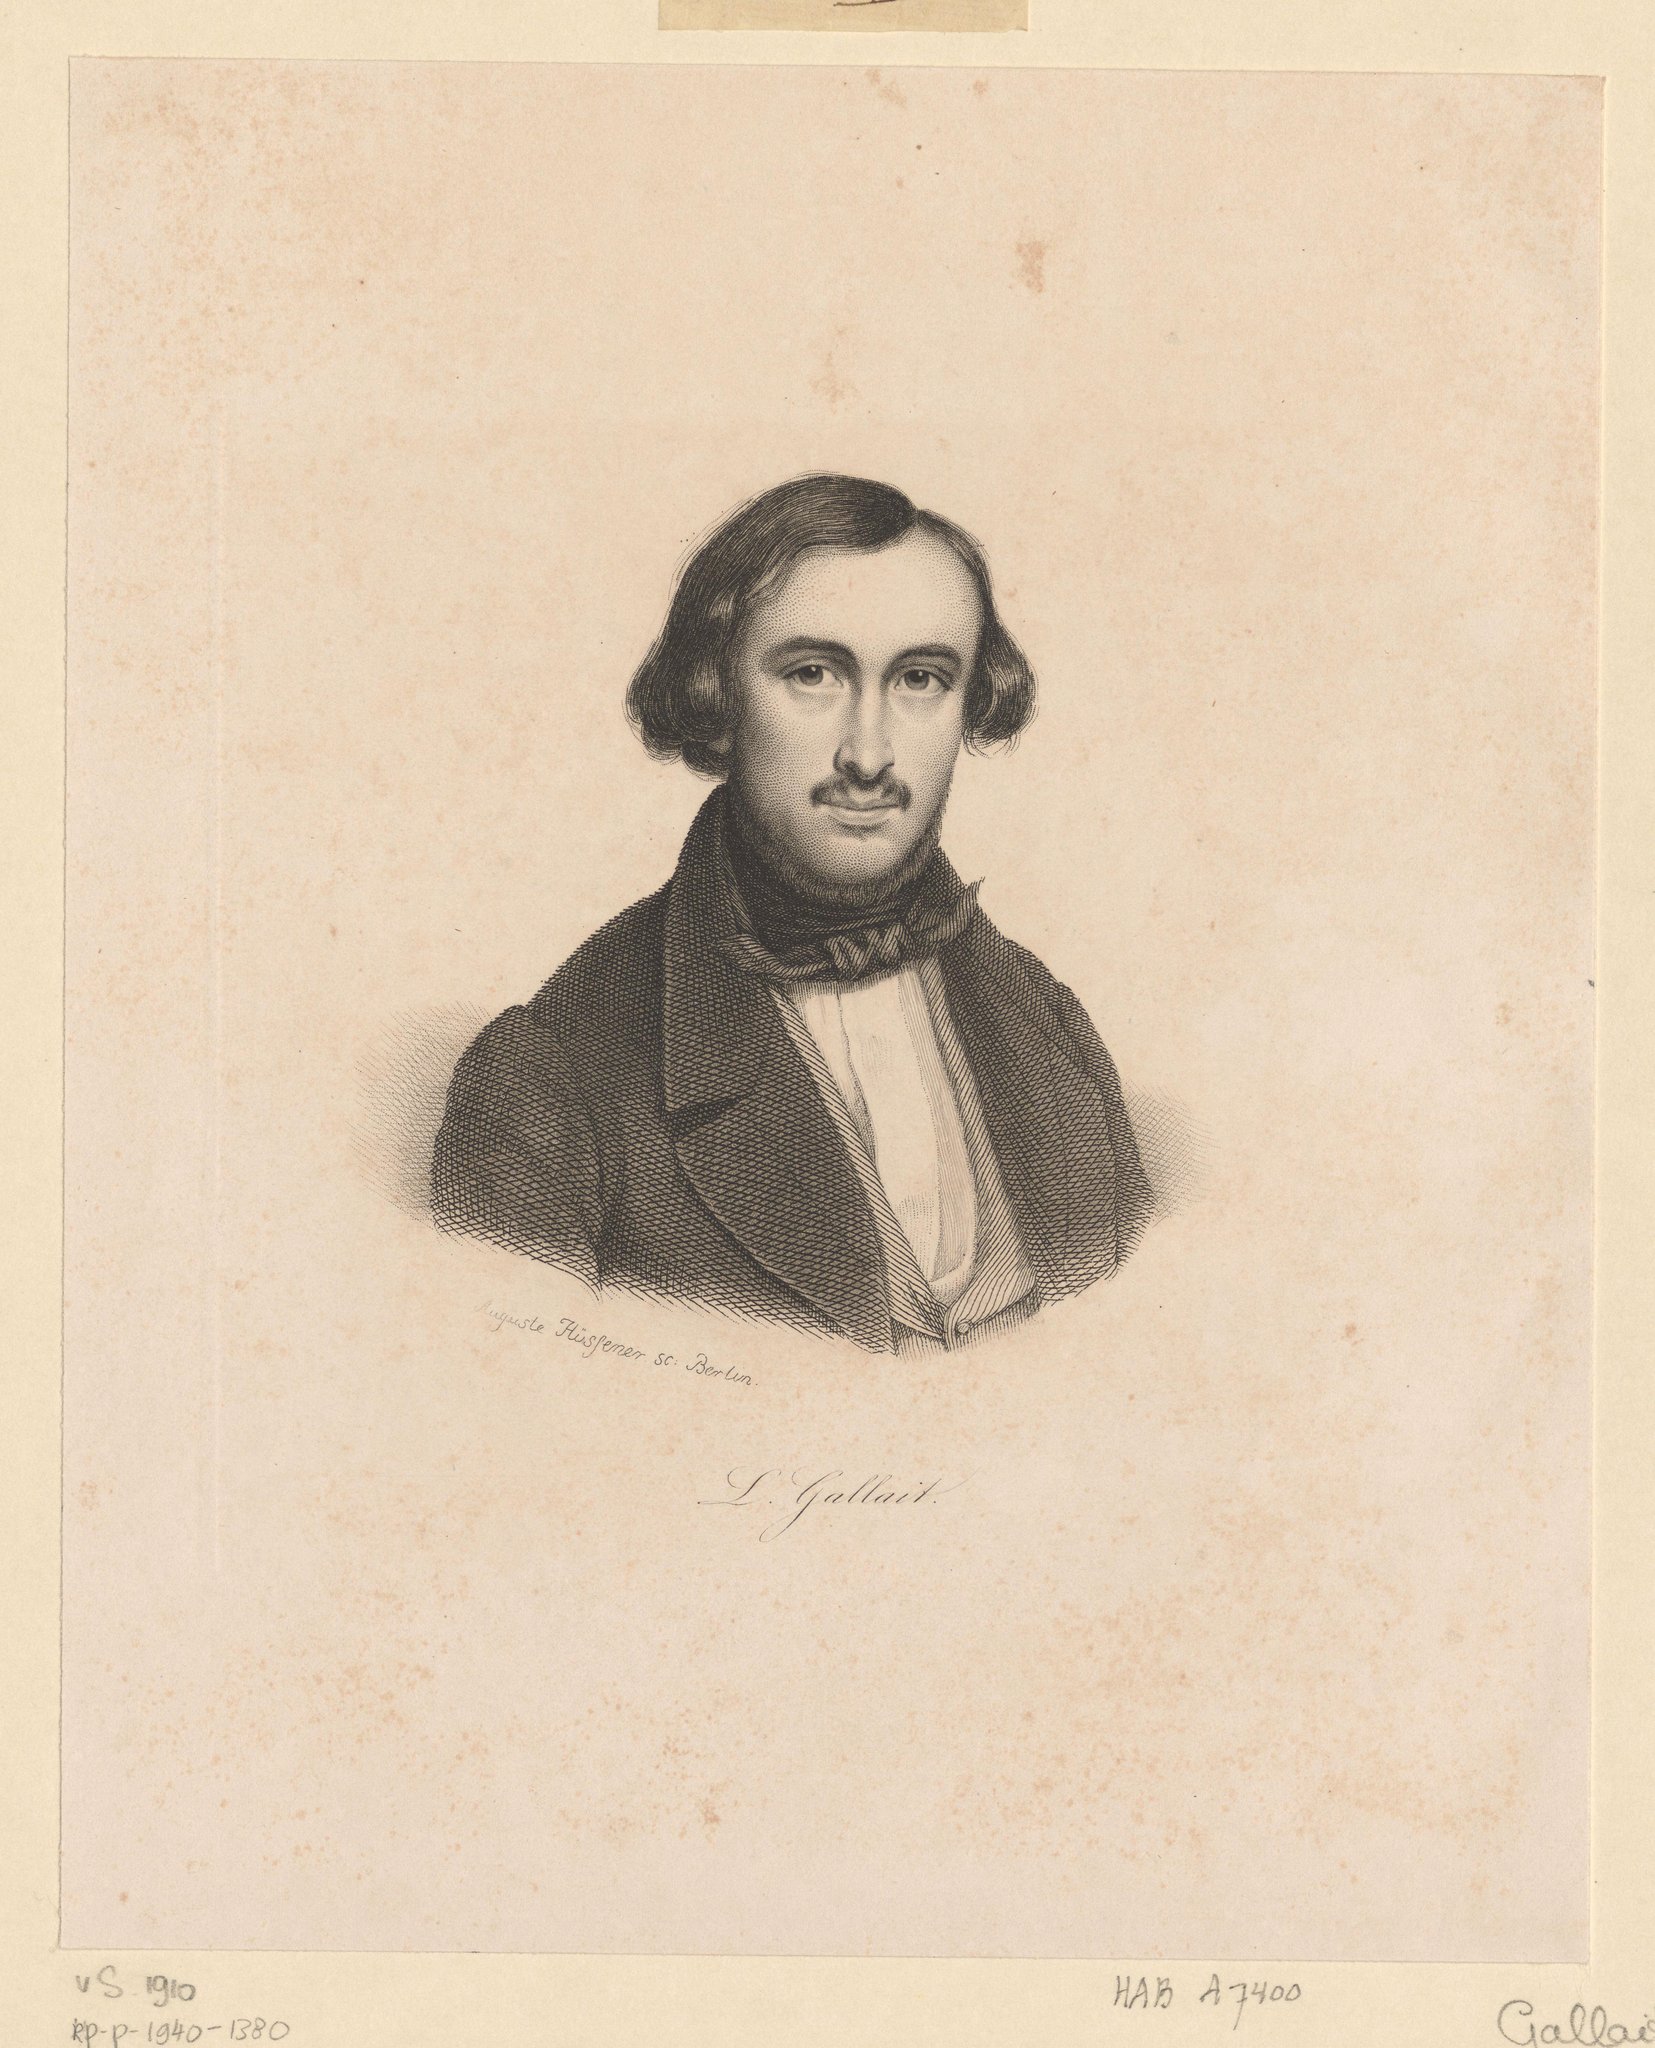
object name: print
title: Portret van Louis Gallait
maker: auguste hüssener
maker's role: print maker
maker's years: 1789-1877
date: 1820-1877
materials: paper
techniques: lithograph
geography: berlin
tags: painter, print maker, draughtsman, louis gallait, historical persons, portrait, self-portrait of painter, portrait, self-portrait of graphic artist, portrait, self-portrait of draughtsman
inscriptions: collector's mark: Lugt 2166, collector's mark: Lugt 2760